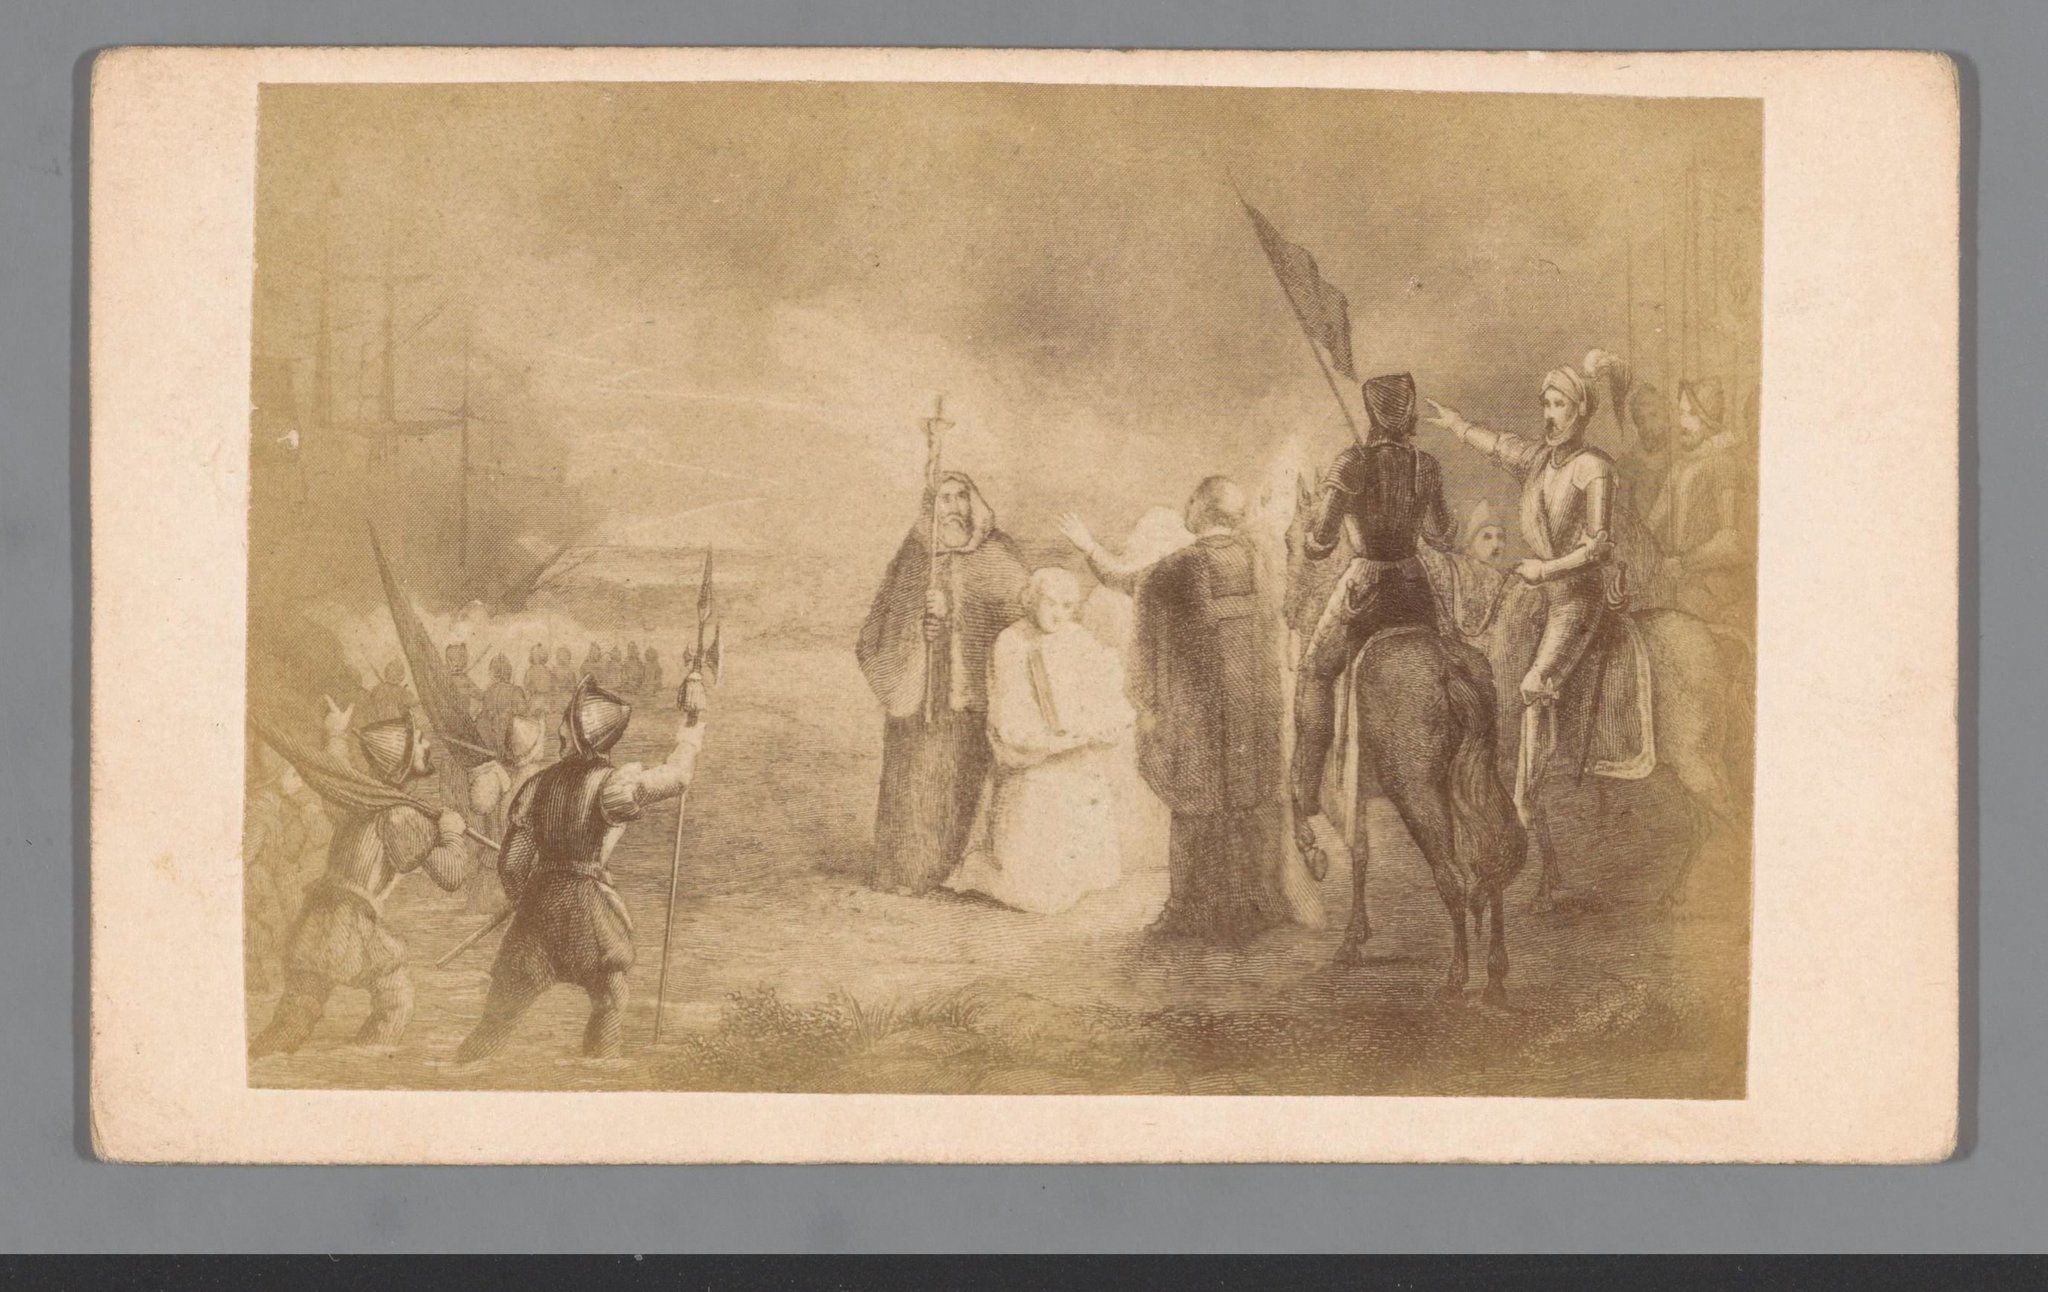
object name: photograph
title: Fotoreproductie van een gravure van de Spanjaarden die door het Zijpe waden op weg naar Zierikzee in 1575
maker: Anonymous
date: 1850-1900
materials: cardboard, photographic support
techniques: albumen print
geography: netherlands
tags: wading, paddling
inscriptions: number: ‘26’, number: ‘26’, inscription: ‘Togt van (...) aan wal.’